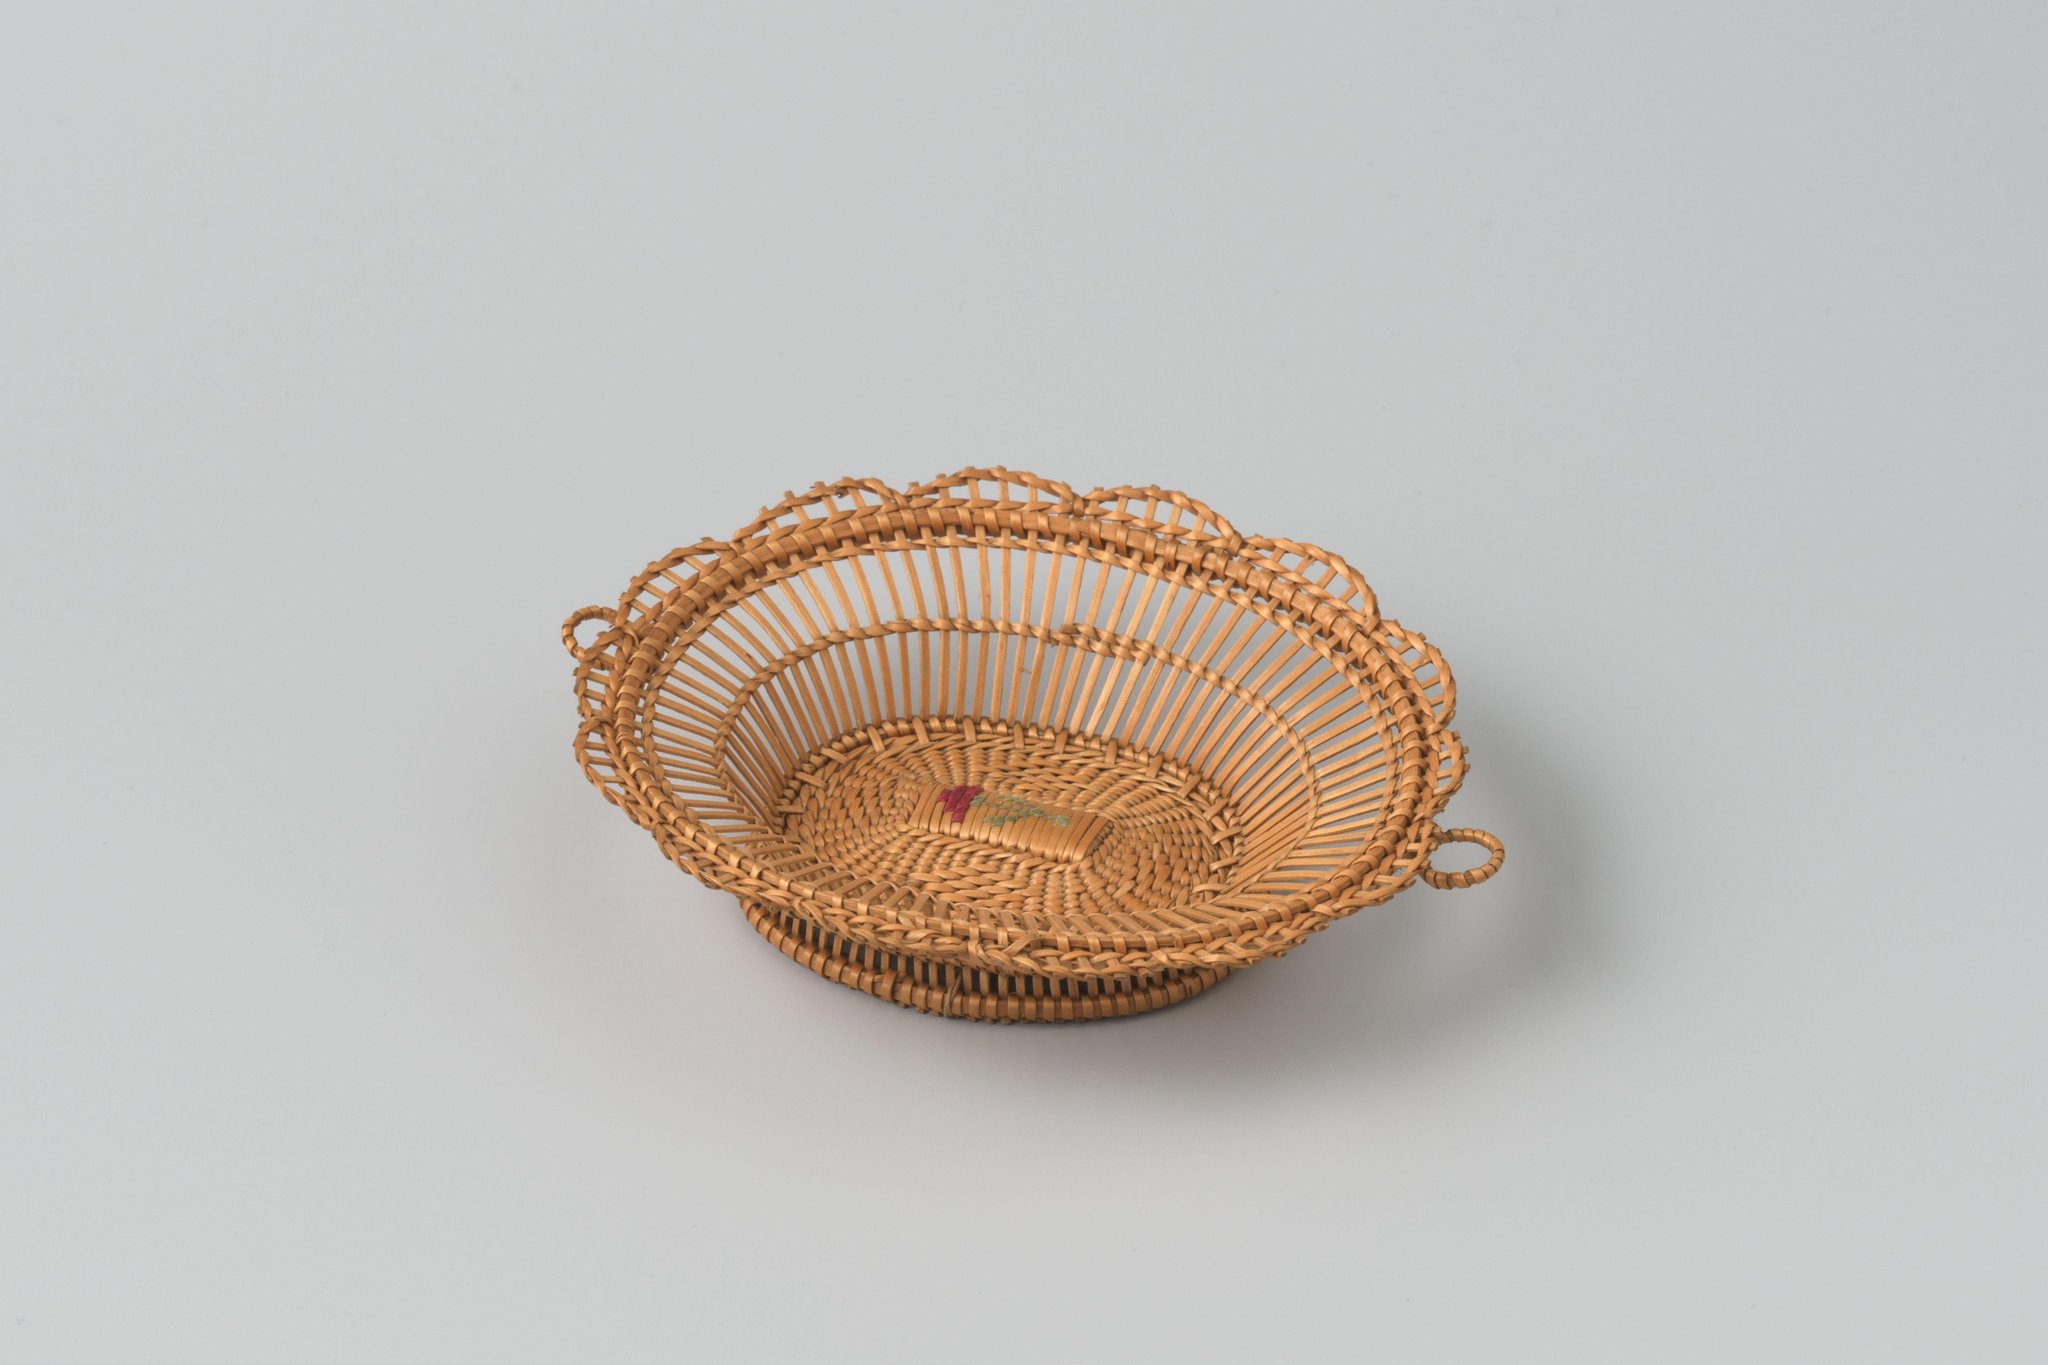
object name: basket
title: Mand, ovaal, vervaardigd van gespleten wilgenteen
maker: Anonymous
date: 1676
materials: plant material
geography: halle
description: Mand, ovaal van vorm, vervaardigd van gespleten wilgenteen, met wijde open rand, fijnscheenwerk. In de bodem zijn ruitmotieven aangebracht. Aan de geschulpte rand zijn twee ringen bevestigd. De bodem is geborduurd met bloemmotief in rode en groene zijde.